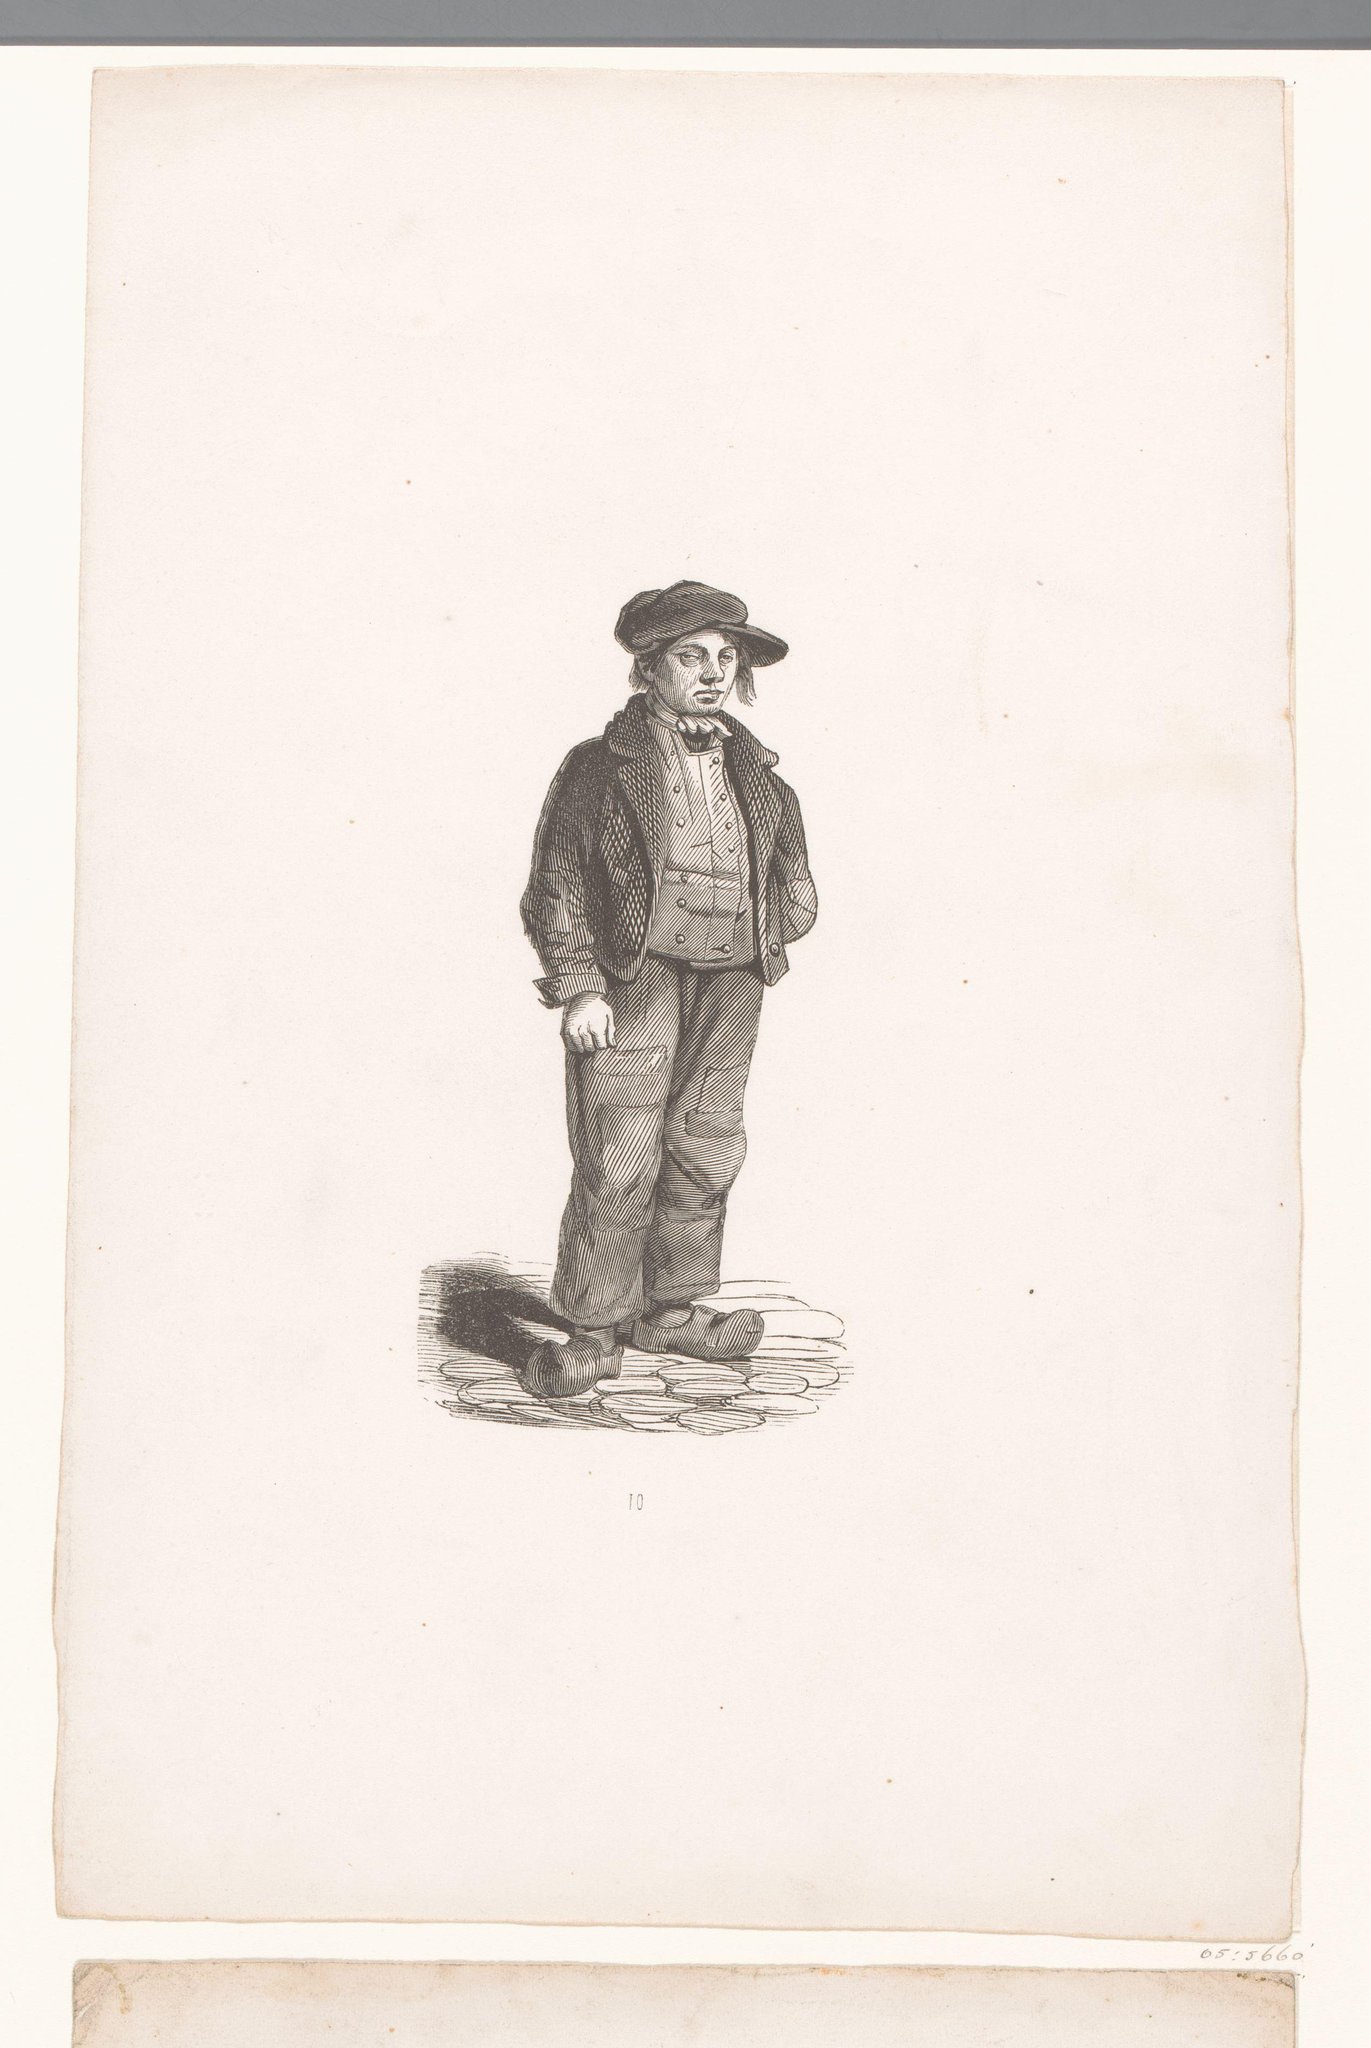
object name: book illustration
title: Straatjongen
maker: henry brown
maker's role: print maker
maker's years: 1816-1870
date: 1841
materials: paper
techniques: engraving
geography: the hague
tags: professional clothes, wooden shoes, clogs, folk costume, regional costume, the poor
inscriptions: collector's mark: Lugt 2228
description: Prent uit: Brown, Henry. De Nederlanden: karakterschetsen, kleederdragten, houding en voorkomen van verschillende standen. Den Haag: Nederlandsche Maatschappij van Schoone Kunsten, 1841.